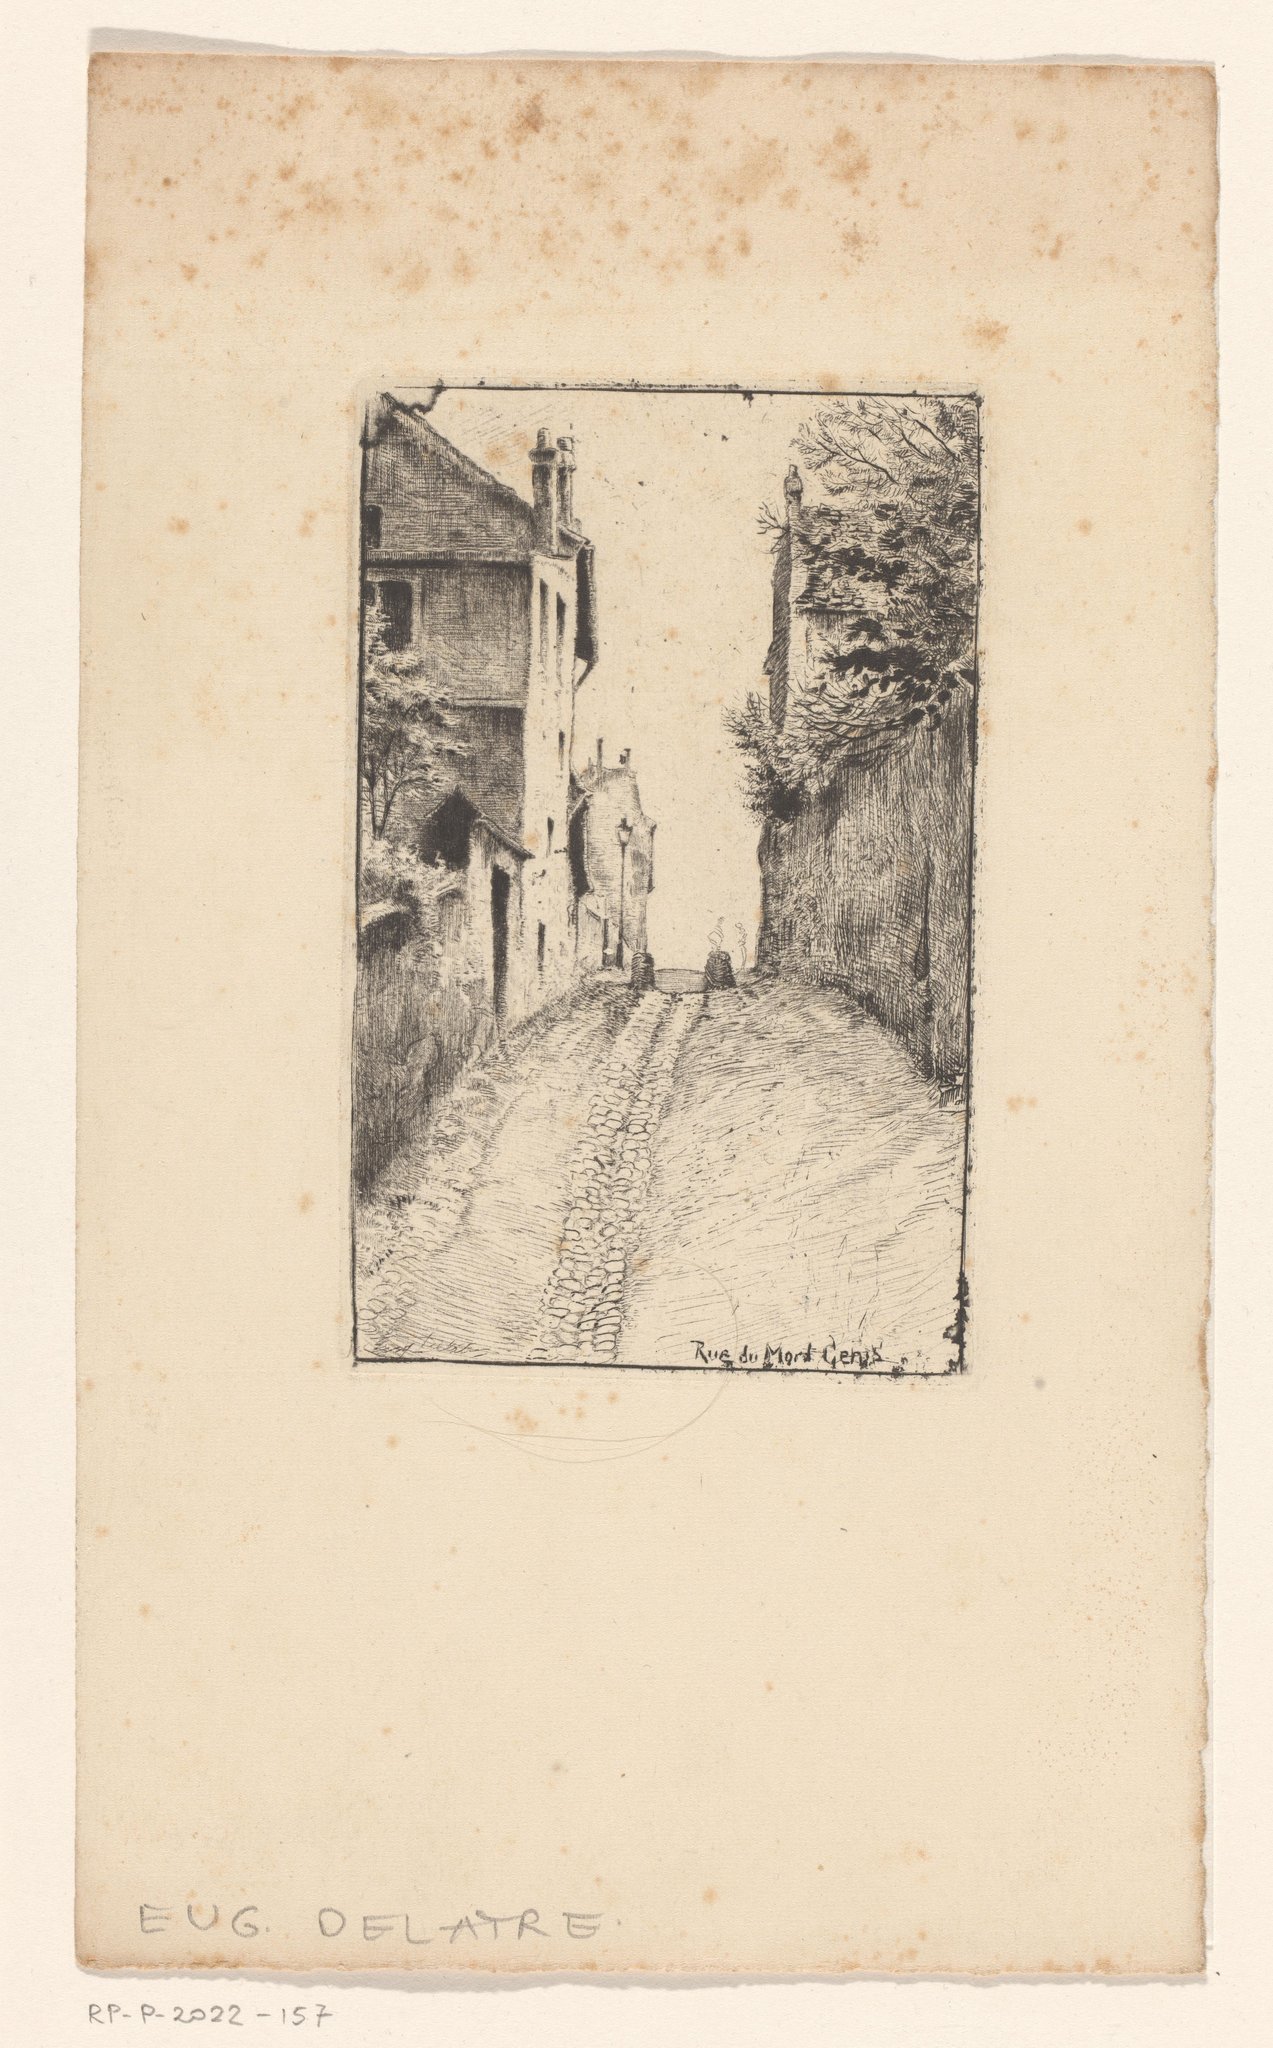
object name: print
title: Rue du Mont Cenis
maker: eugène delâtre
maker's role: print maker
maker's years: 1864-1938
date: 1891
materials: paper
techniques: etching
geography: paris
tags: public road, paris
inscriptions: collector's mark: Lugt 2760, collector's mark: Lugt 2228